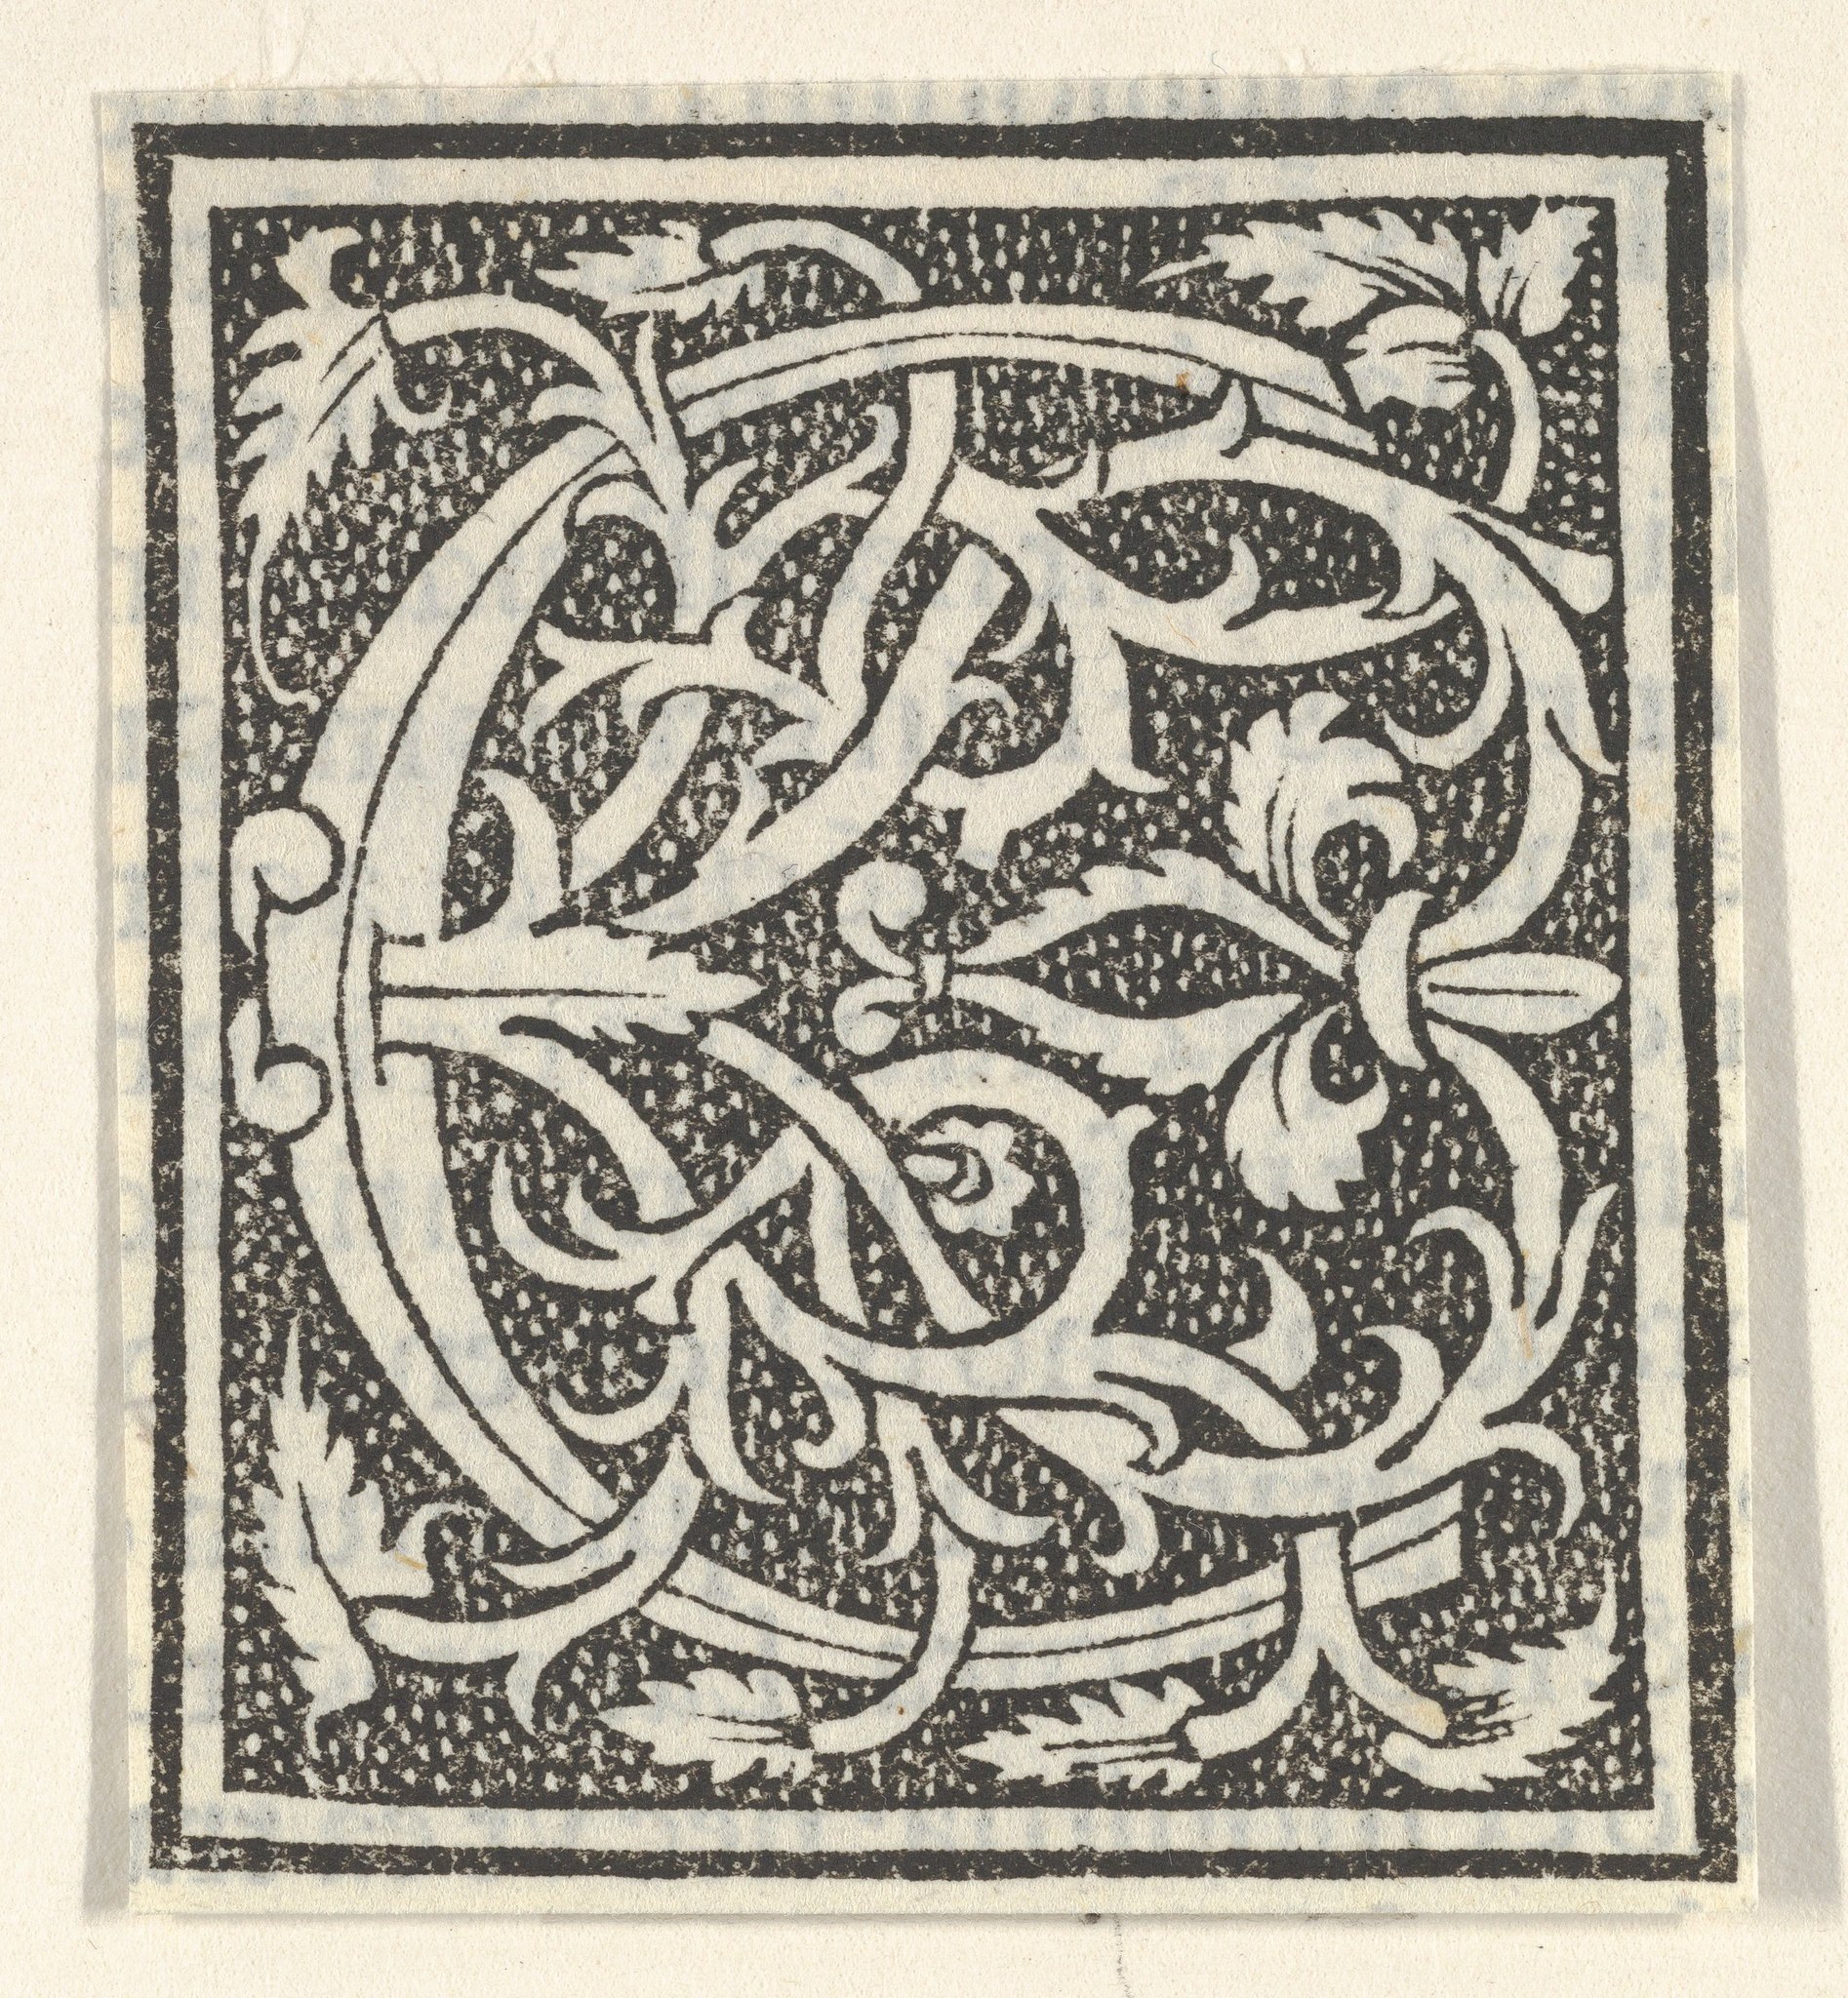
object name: print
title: Initial letter C on patterned background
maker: anonymous, italian, 16th century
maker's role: artist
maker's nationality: italian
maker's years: 1500-1600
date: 1520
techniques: woodcut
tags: leaves,insignia